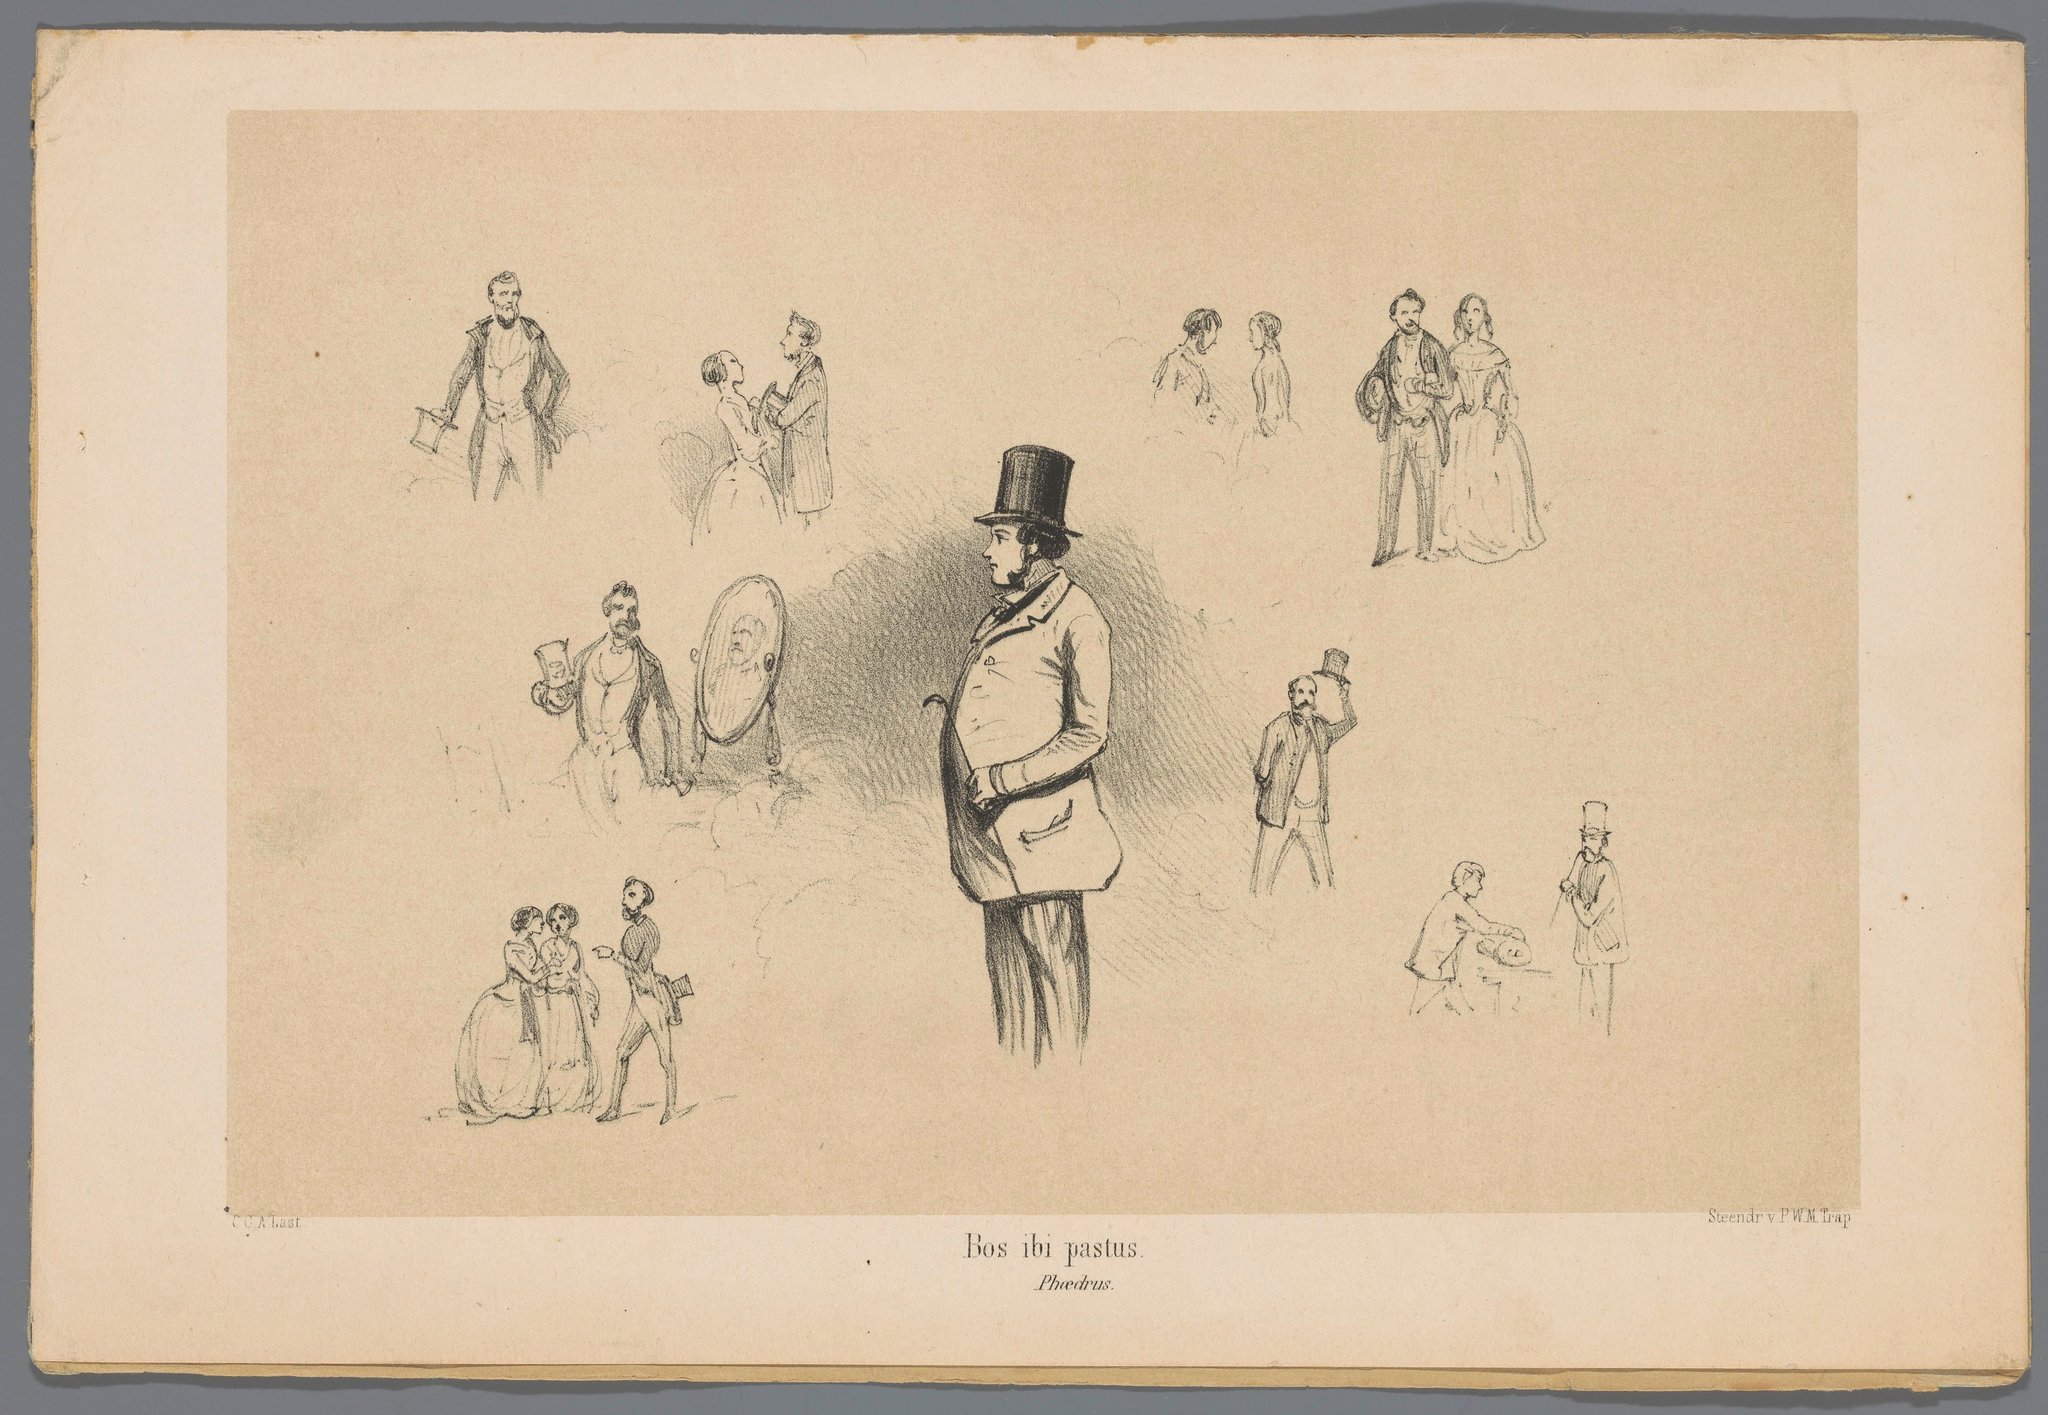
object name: print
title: Tien jaren later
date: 1836-1867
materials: paper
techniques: tone lithography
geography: leiden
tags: bourgeoisie, middle class, citizens, burghers, whip, head-gear: top hat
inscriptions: collector's mark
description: De serie met omslag werd samengesteld door Jan van der Hoeven (Leiden 1834 - Rotterdam 1900). Van der Hoeven was mede oprichter van het Sophia-Kinderziekenhuis in Rotterdam en was als heelmeester verbonden aan het stedelijk ziekenhuis aldaar.